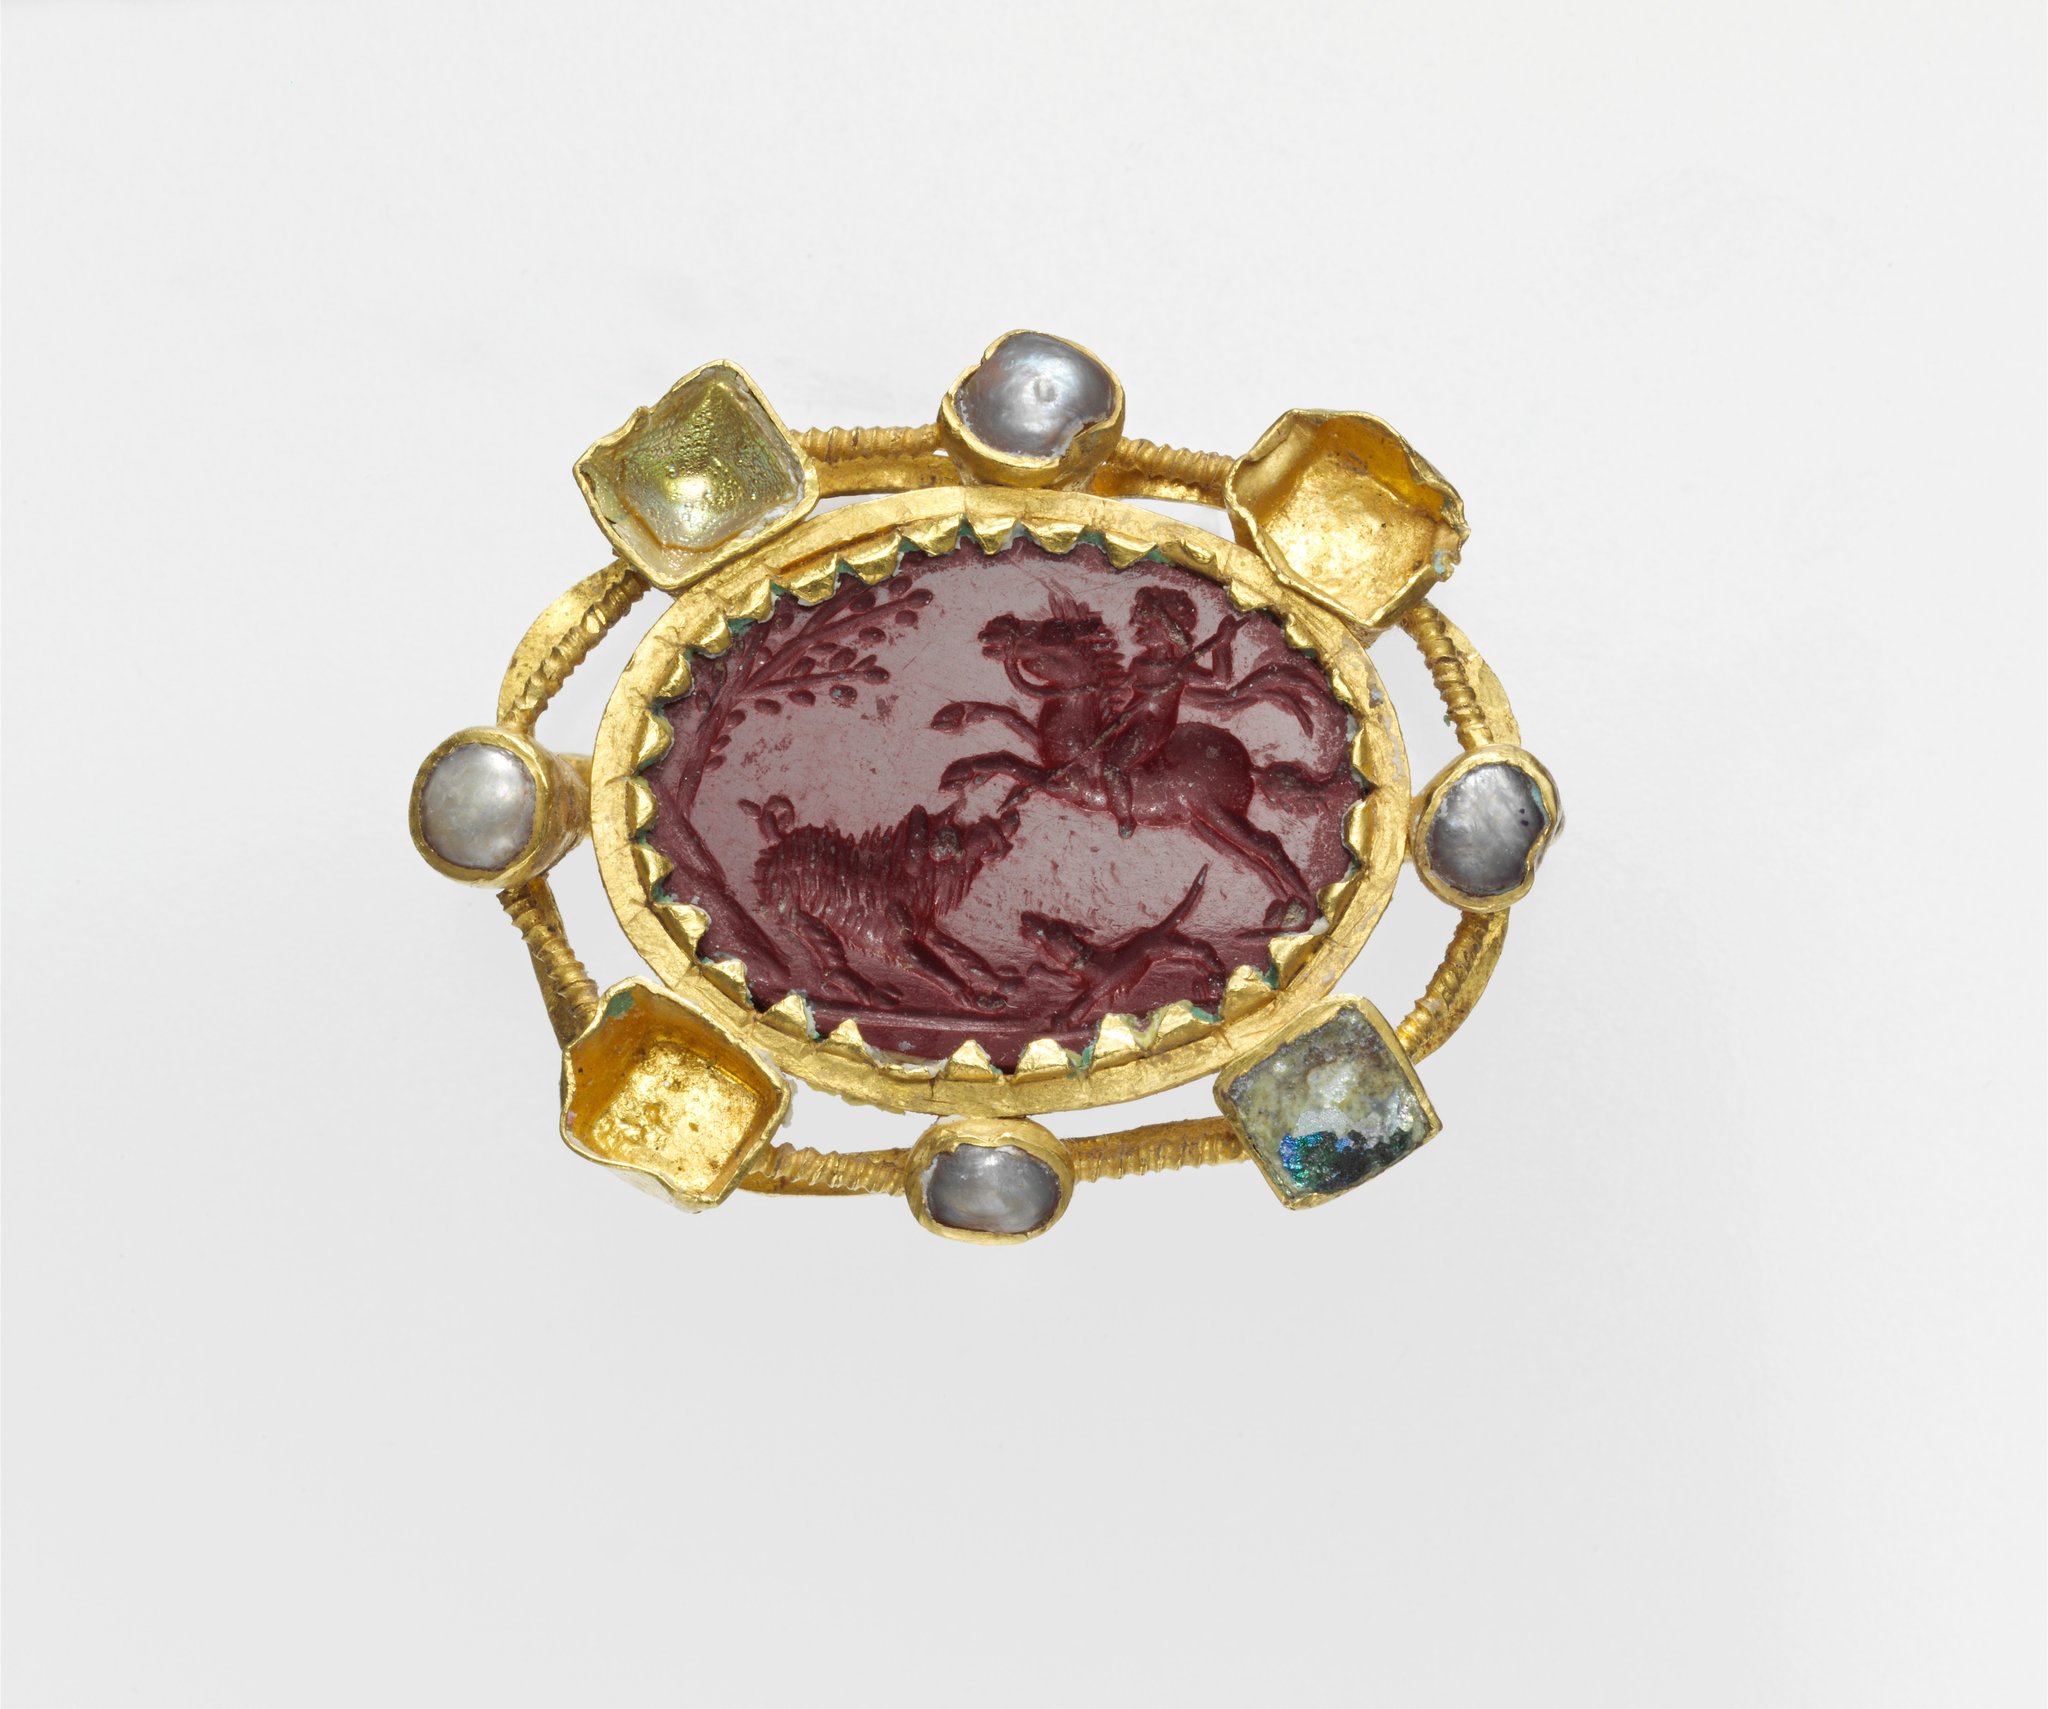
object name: intaglio with pearl and glass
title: Jasper intaglio in a gold mount set with pearls and glass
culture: roman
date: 101-300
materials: glass, gold, jasper, pearl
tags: men,hunting,boars,dogs,horses